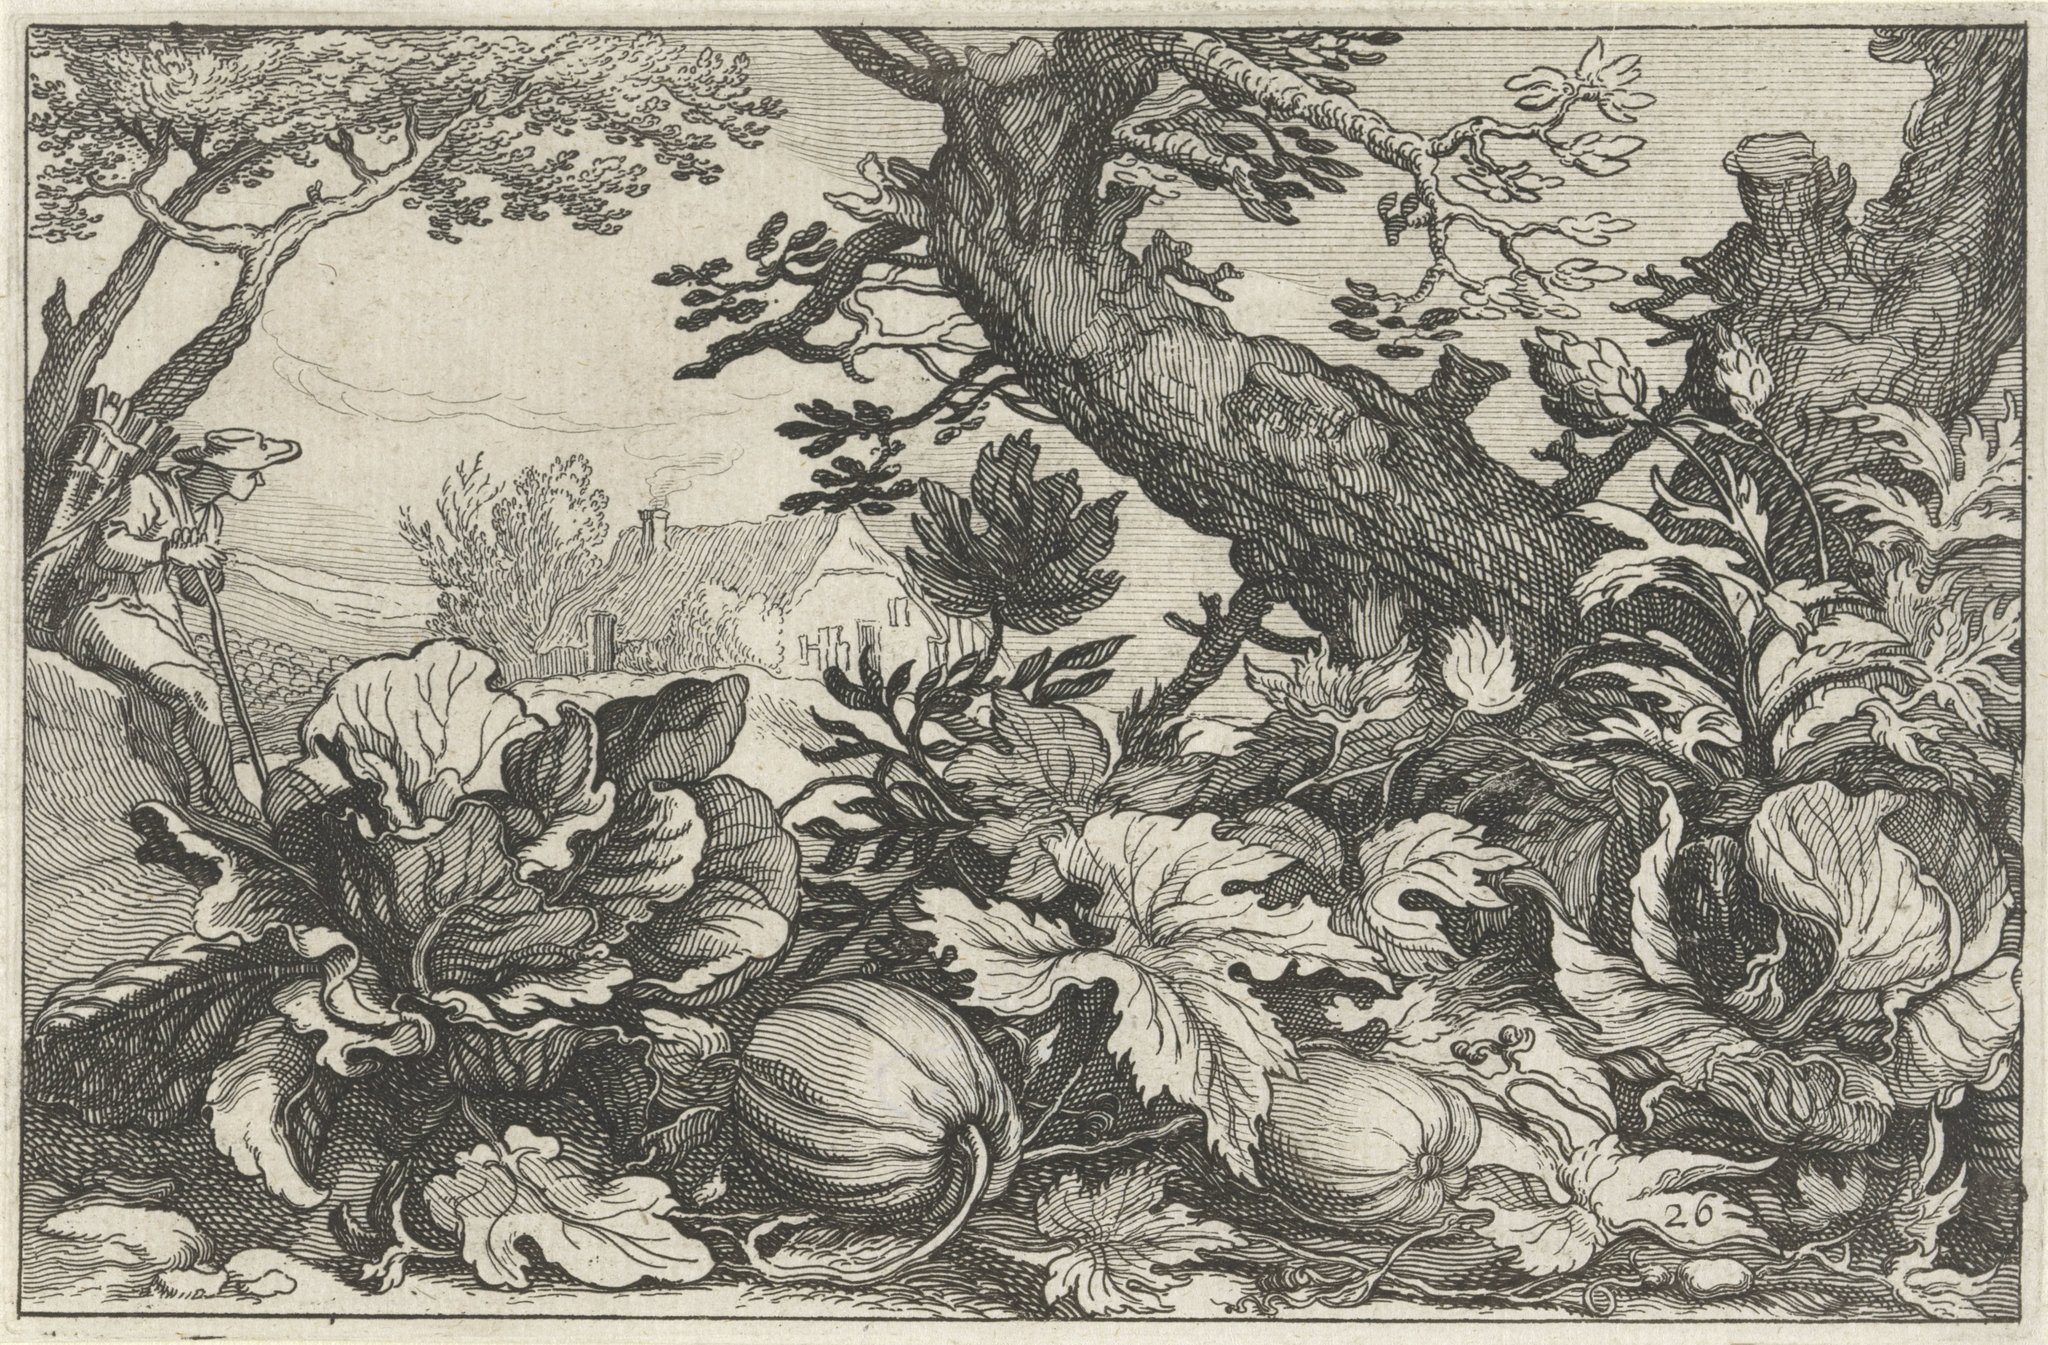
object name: print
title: Landschap met pompoenen en kolen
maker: claes jansz. visscher (ii)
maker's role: draughtsman, print maker, publisher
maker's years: 1586-1652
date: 1620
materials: paper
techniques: etching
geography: amsterdam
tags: landscapes, farm or solitary house in landscape, plants and herbs: pumpkin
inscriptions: number: ‘26’ Lugt, collector's mark: 2228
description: Landschap met pompoenen en kolen op de voorgrond en links een herder. Op de achtergrond een boerderij met een rokende schoorsteen.